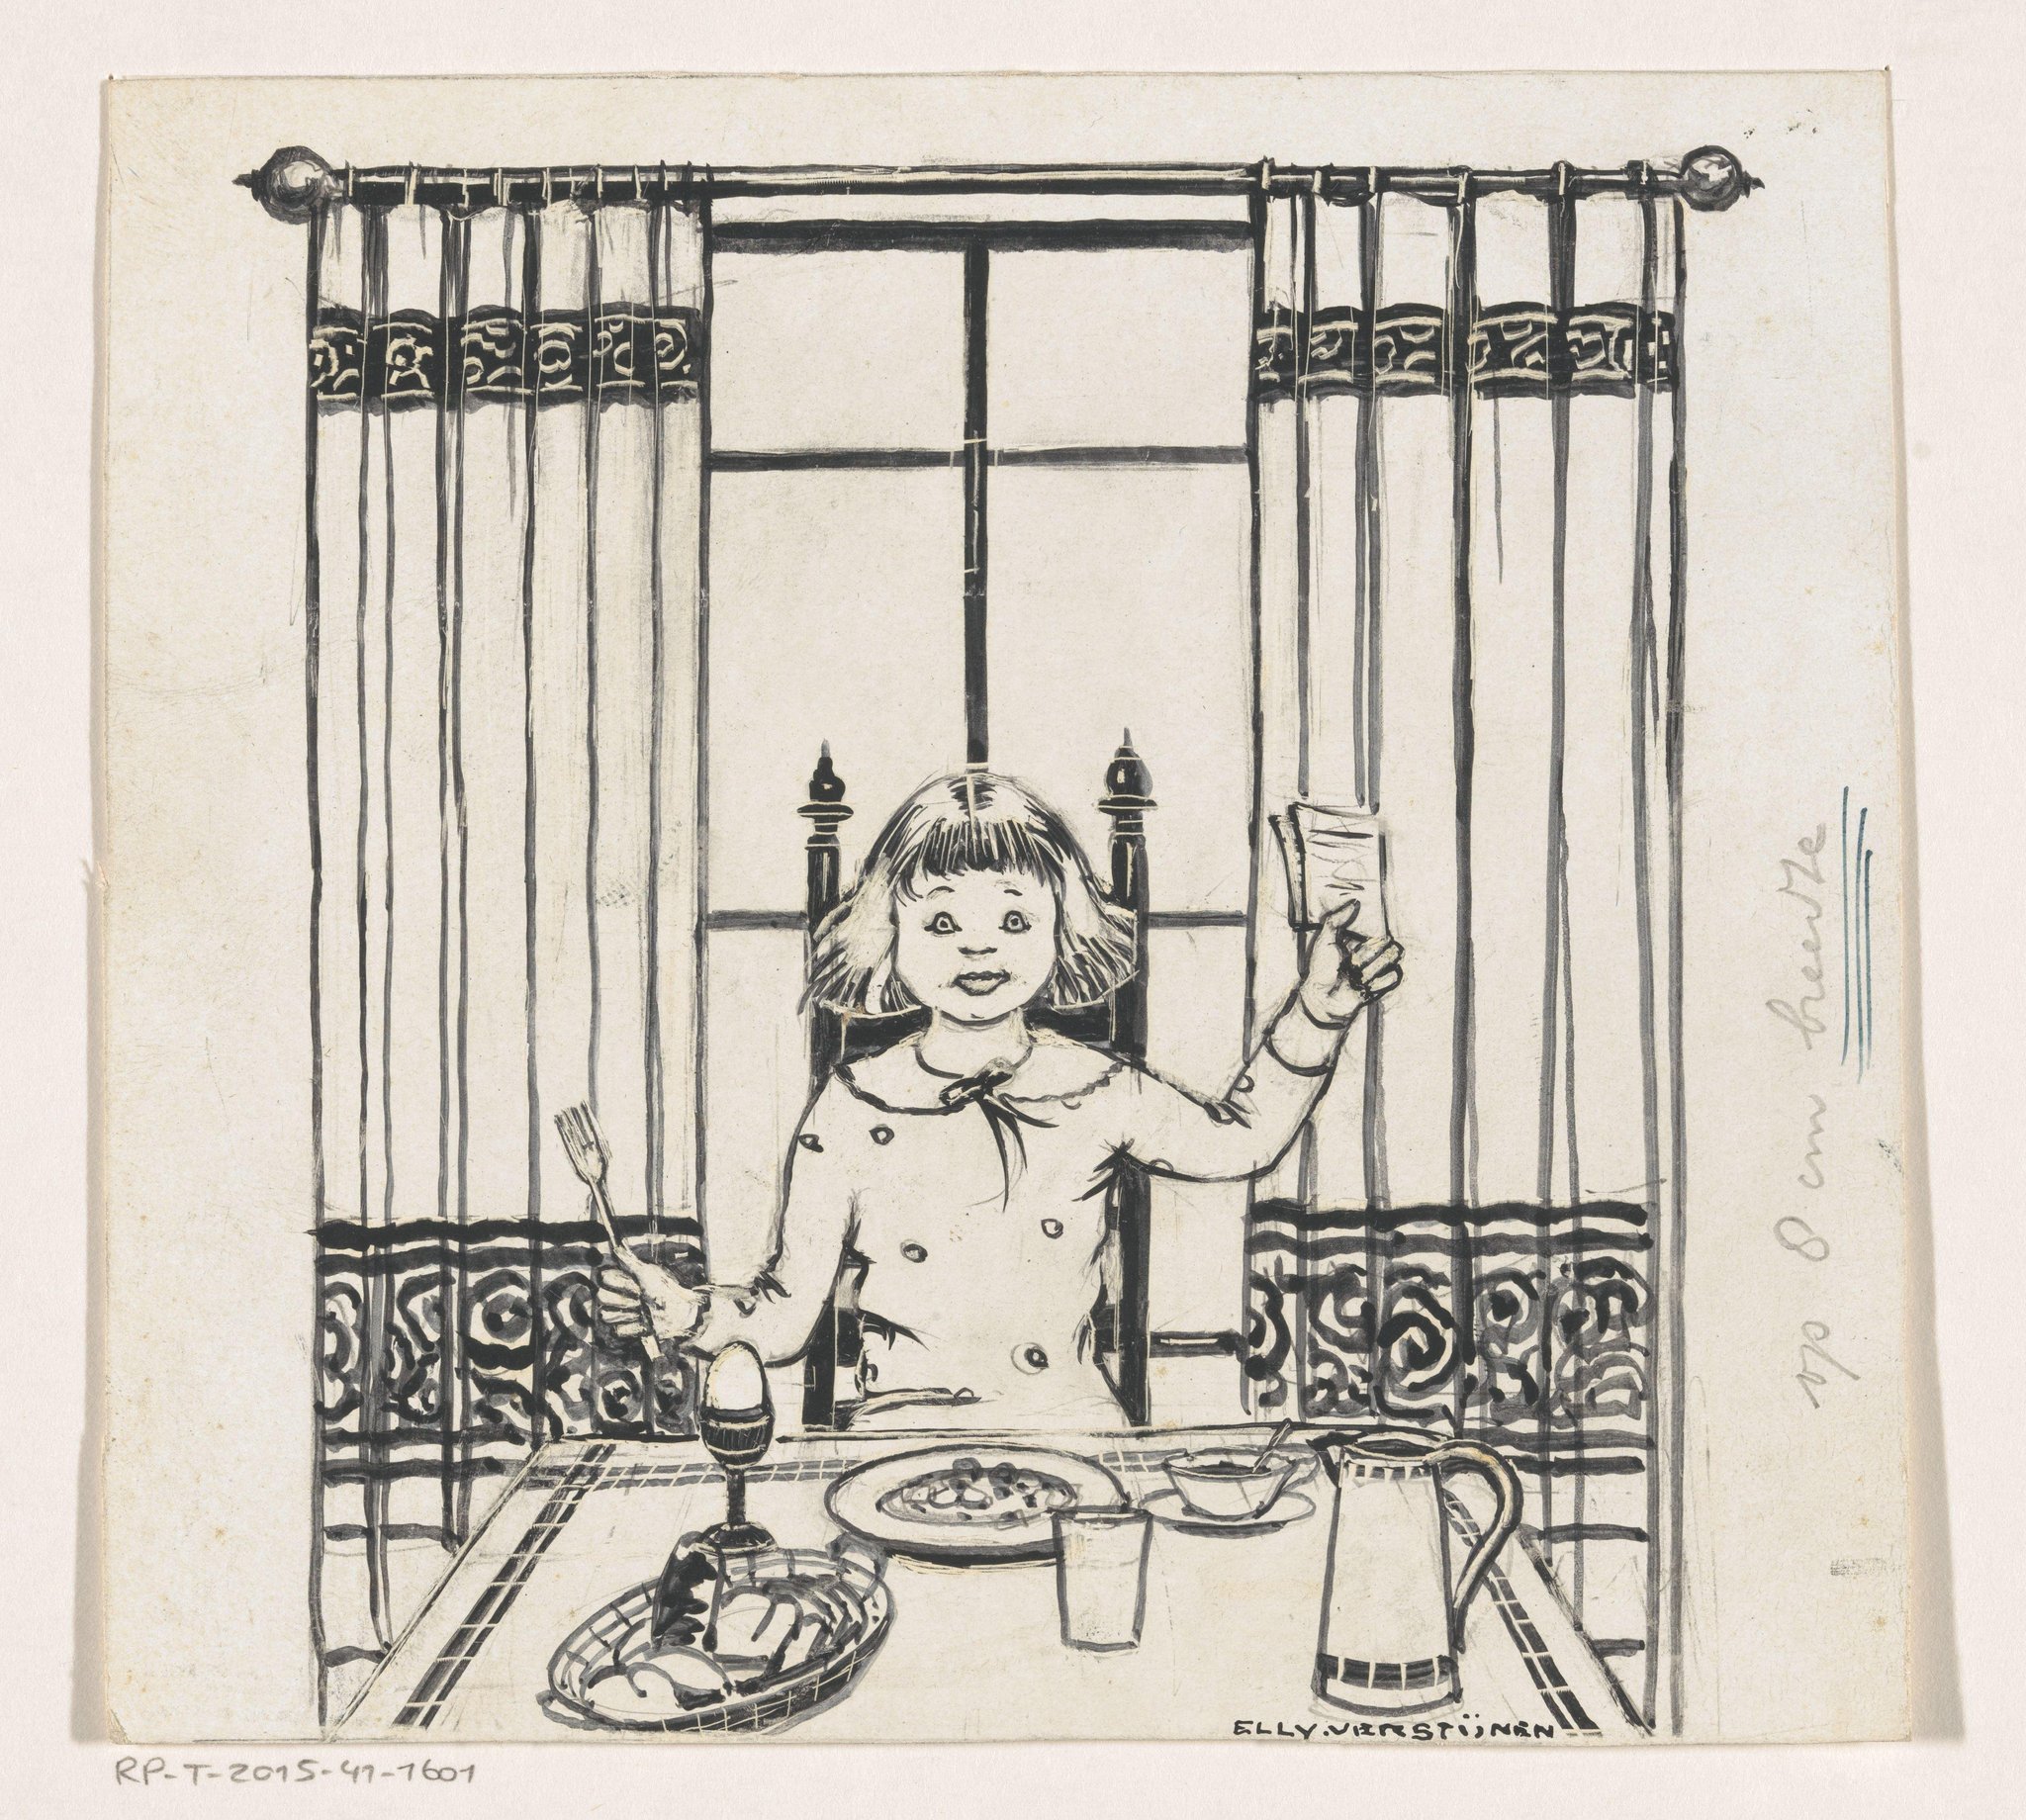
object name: boekillustratie ontwerp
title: Meisje met brief aan een tafel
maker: elly verstijnen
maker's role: draughtsman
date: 1900-1930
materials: ink, paper, pencil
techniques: brush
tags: letter, envelope, laid table: table-ware, table-decoration, etc.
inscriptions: :, annotation: ‘Februari 3’, collector's mark: Lugt 2228, signature: ‘ELLY.VERSTIJNEN’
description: Een meisje zit aan een maaltijd aan een gedekte tafel. Op tafel staan onder andere een mand met brood, een gekookt ei en een bord. Het meisje heeft een vork in haar ene hand en houdt met haar andere hand een brief omhoog.